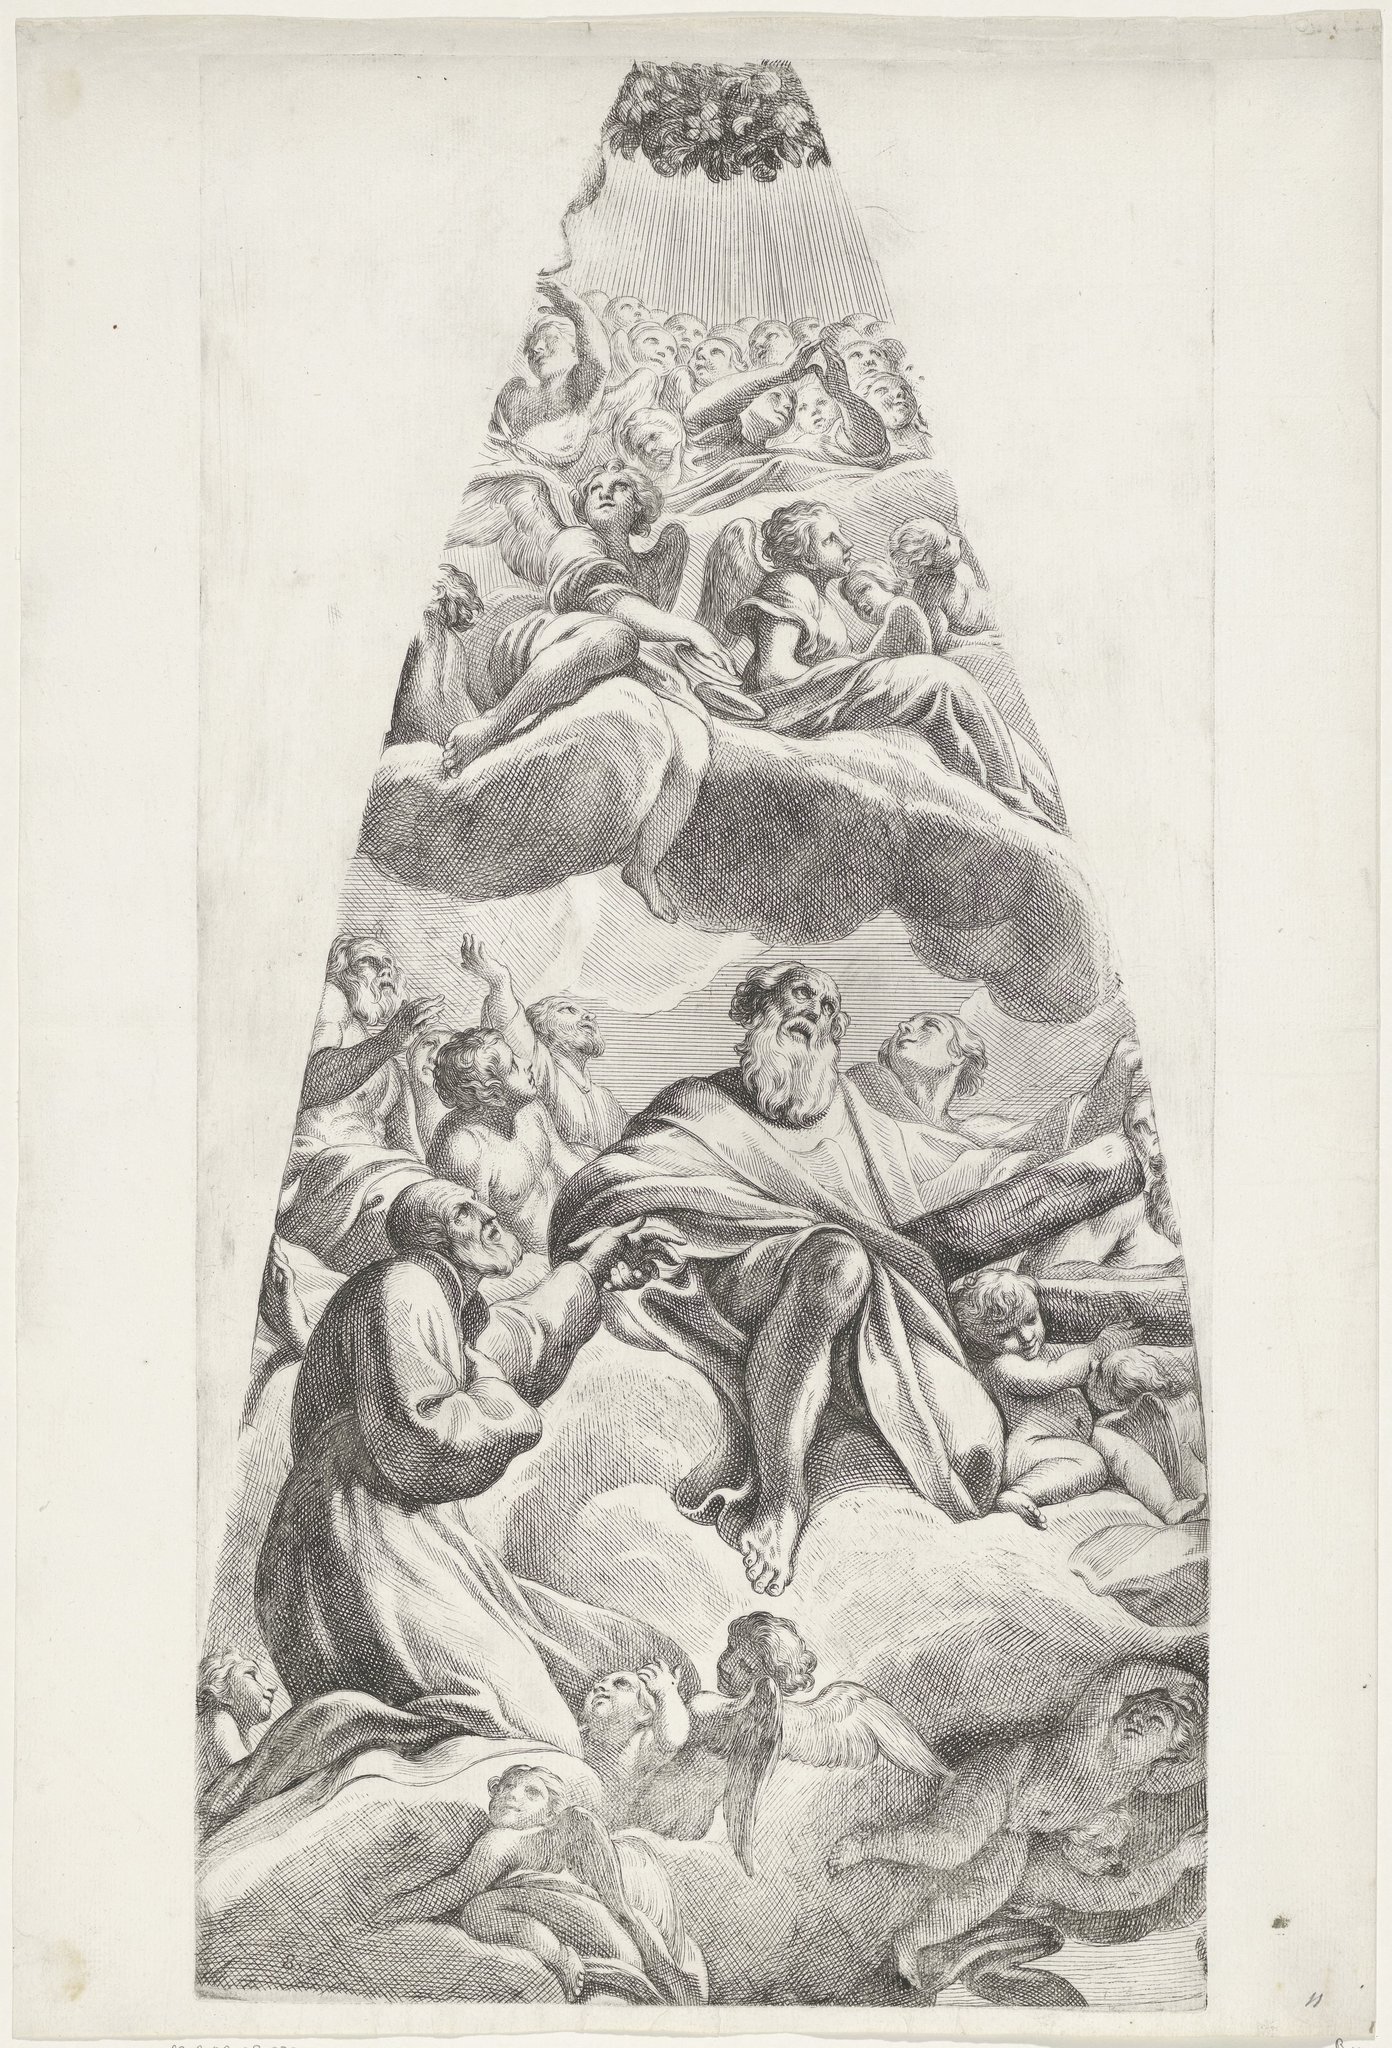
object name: print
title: Hemelvaart van Maria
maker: carlo cesio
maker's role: painter, print maker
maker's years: 1622-1682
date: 1636-1686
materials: paper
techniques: engraving, etching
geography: italy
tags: saints, angels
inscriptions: collector's mark: Lugt 240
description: Prent uit een reeks van 8 prenten naar de fresco's door Giovanni Lanfranco in de koepel van de San Andrea della Valle te Rome.